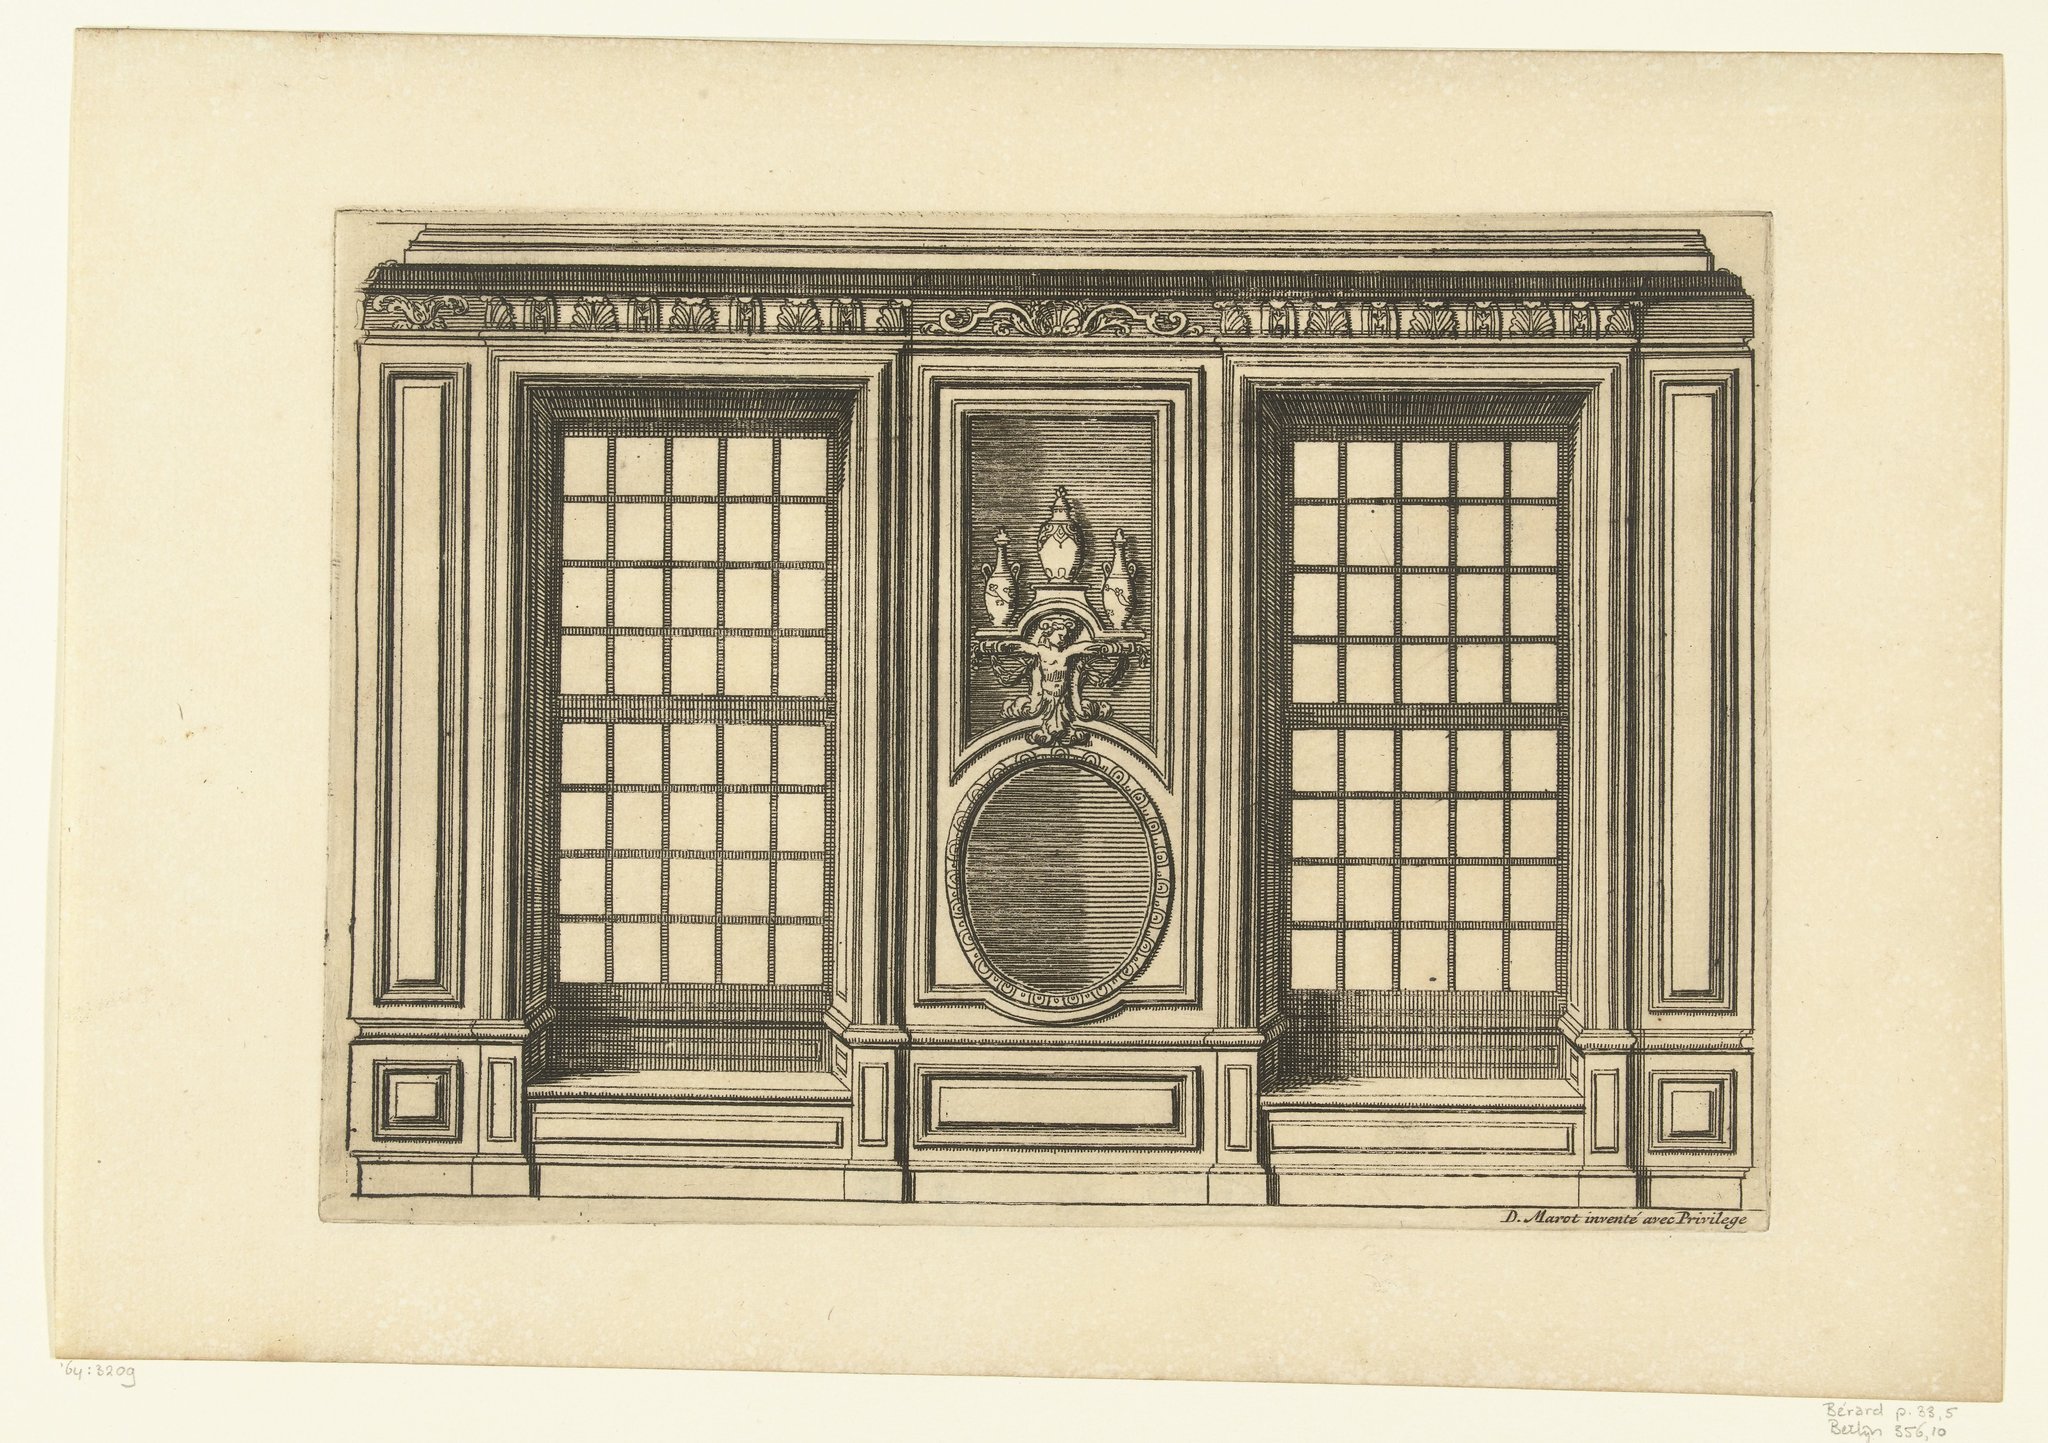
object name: print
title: Nouveaux Liure de Lembris et Revestement à Panneaux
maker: daniël marot (i)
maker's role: draughtsman, print maker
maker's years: 1661-1752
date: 1703-1712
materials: paper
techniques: etching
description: De muurdam is versierd met een ovale spiegel en een console waarop drie Chinese vazen staan. De console wordt ondersteund door een herme. Uit serie van 6 bladen.